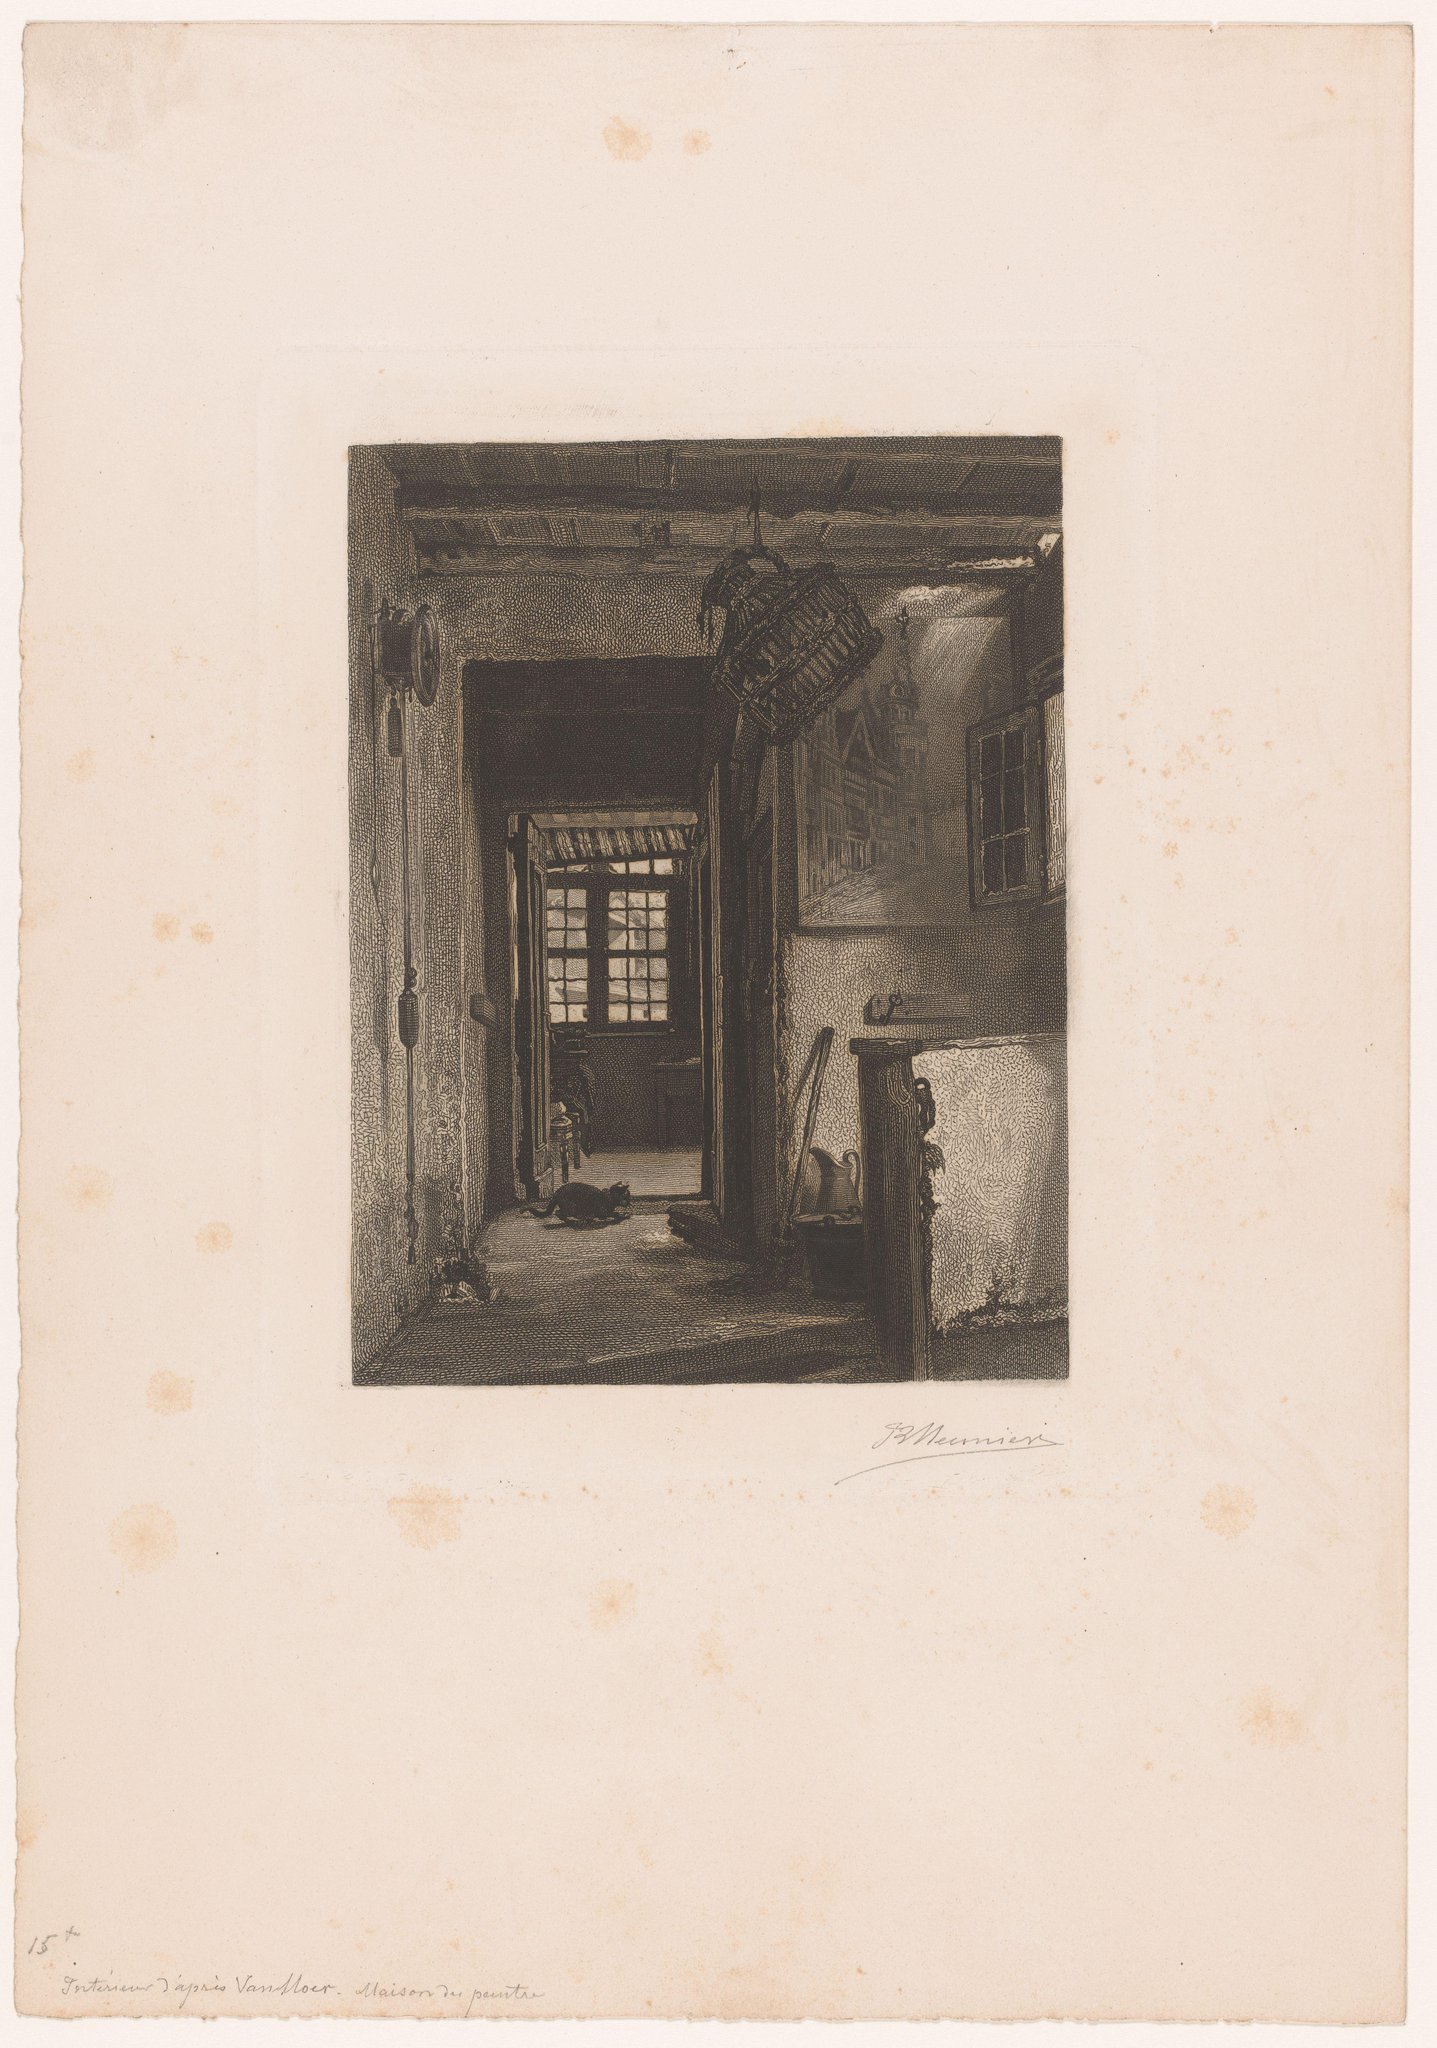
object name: print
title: Interieur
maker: jean-baptiste meunier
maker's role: print maker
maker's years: 1821-1900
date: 1831-1888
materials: paper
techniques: etching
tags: cat, interior ~ representation of a building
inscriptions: collector's mark: Lugt 2228